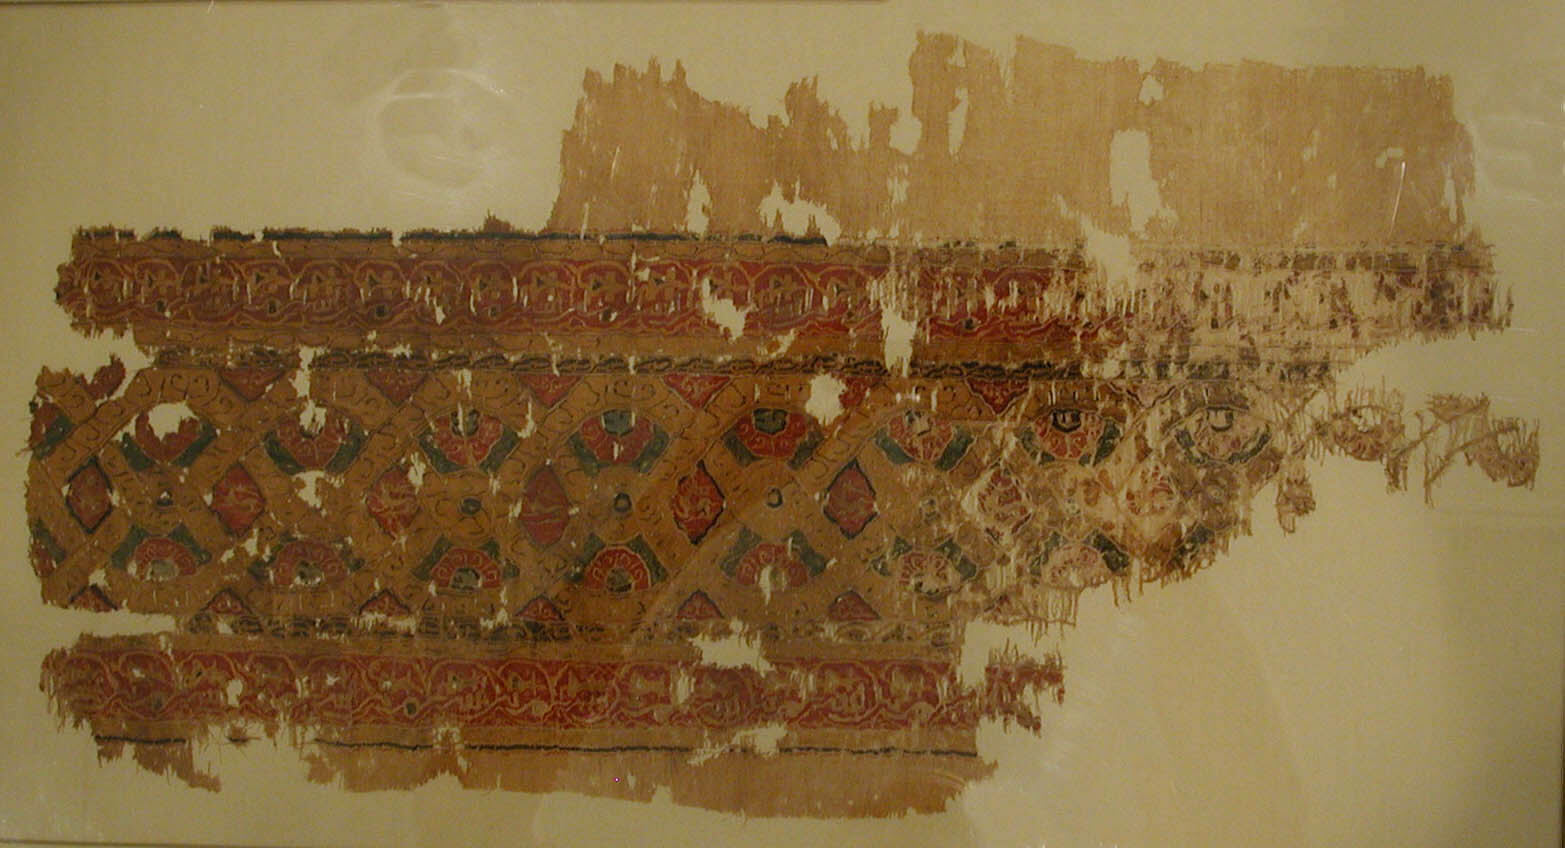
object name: textile fragment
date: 901-1100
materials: linen, silk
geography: egypt